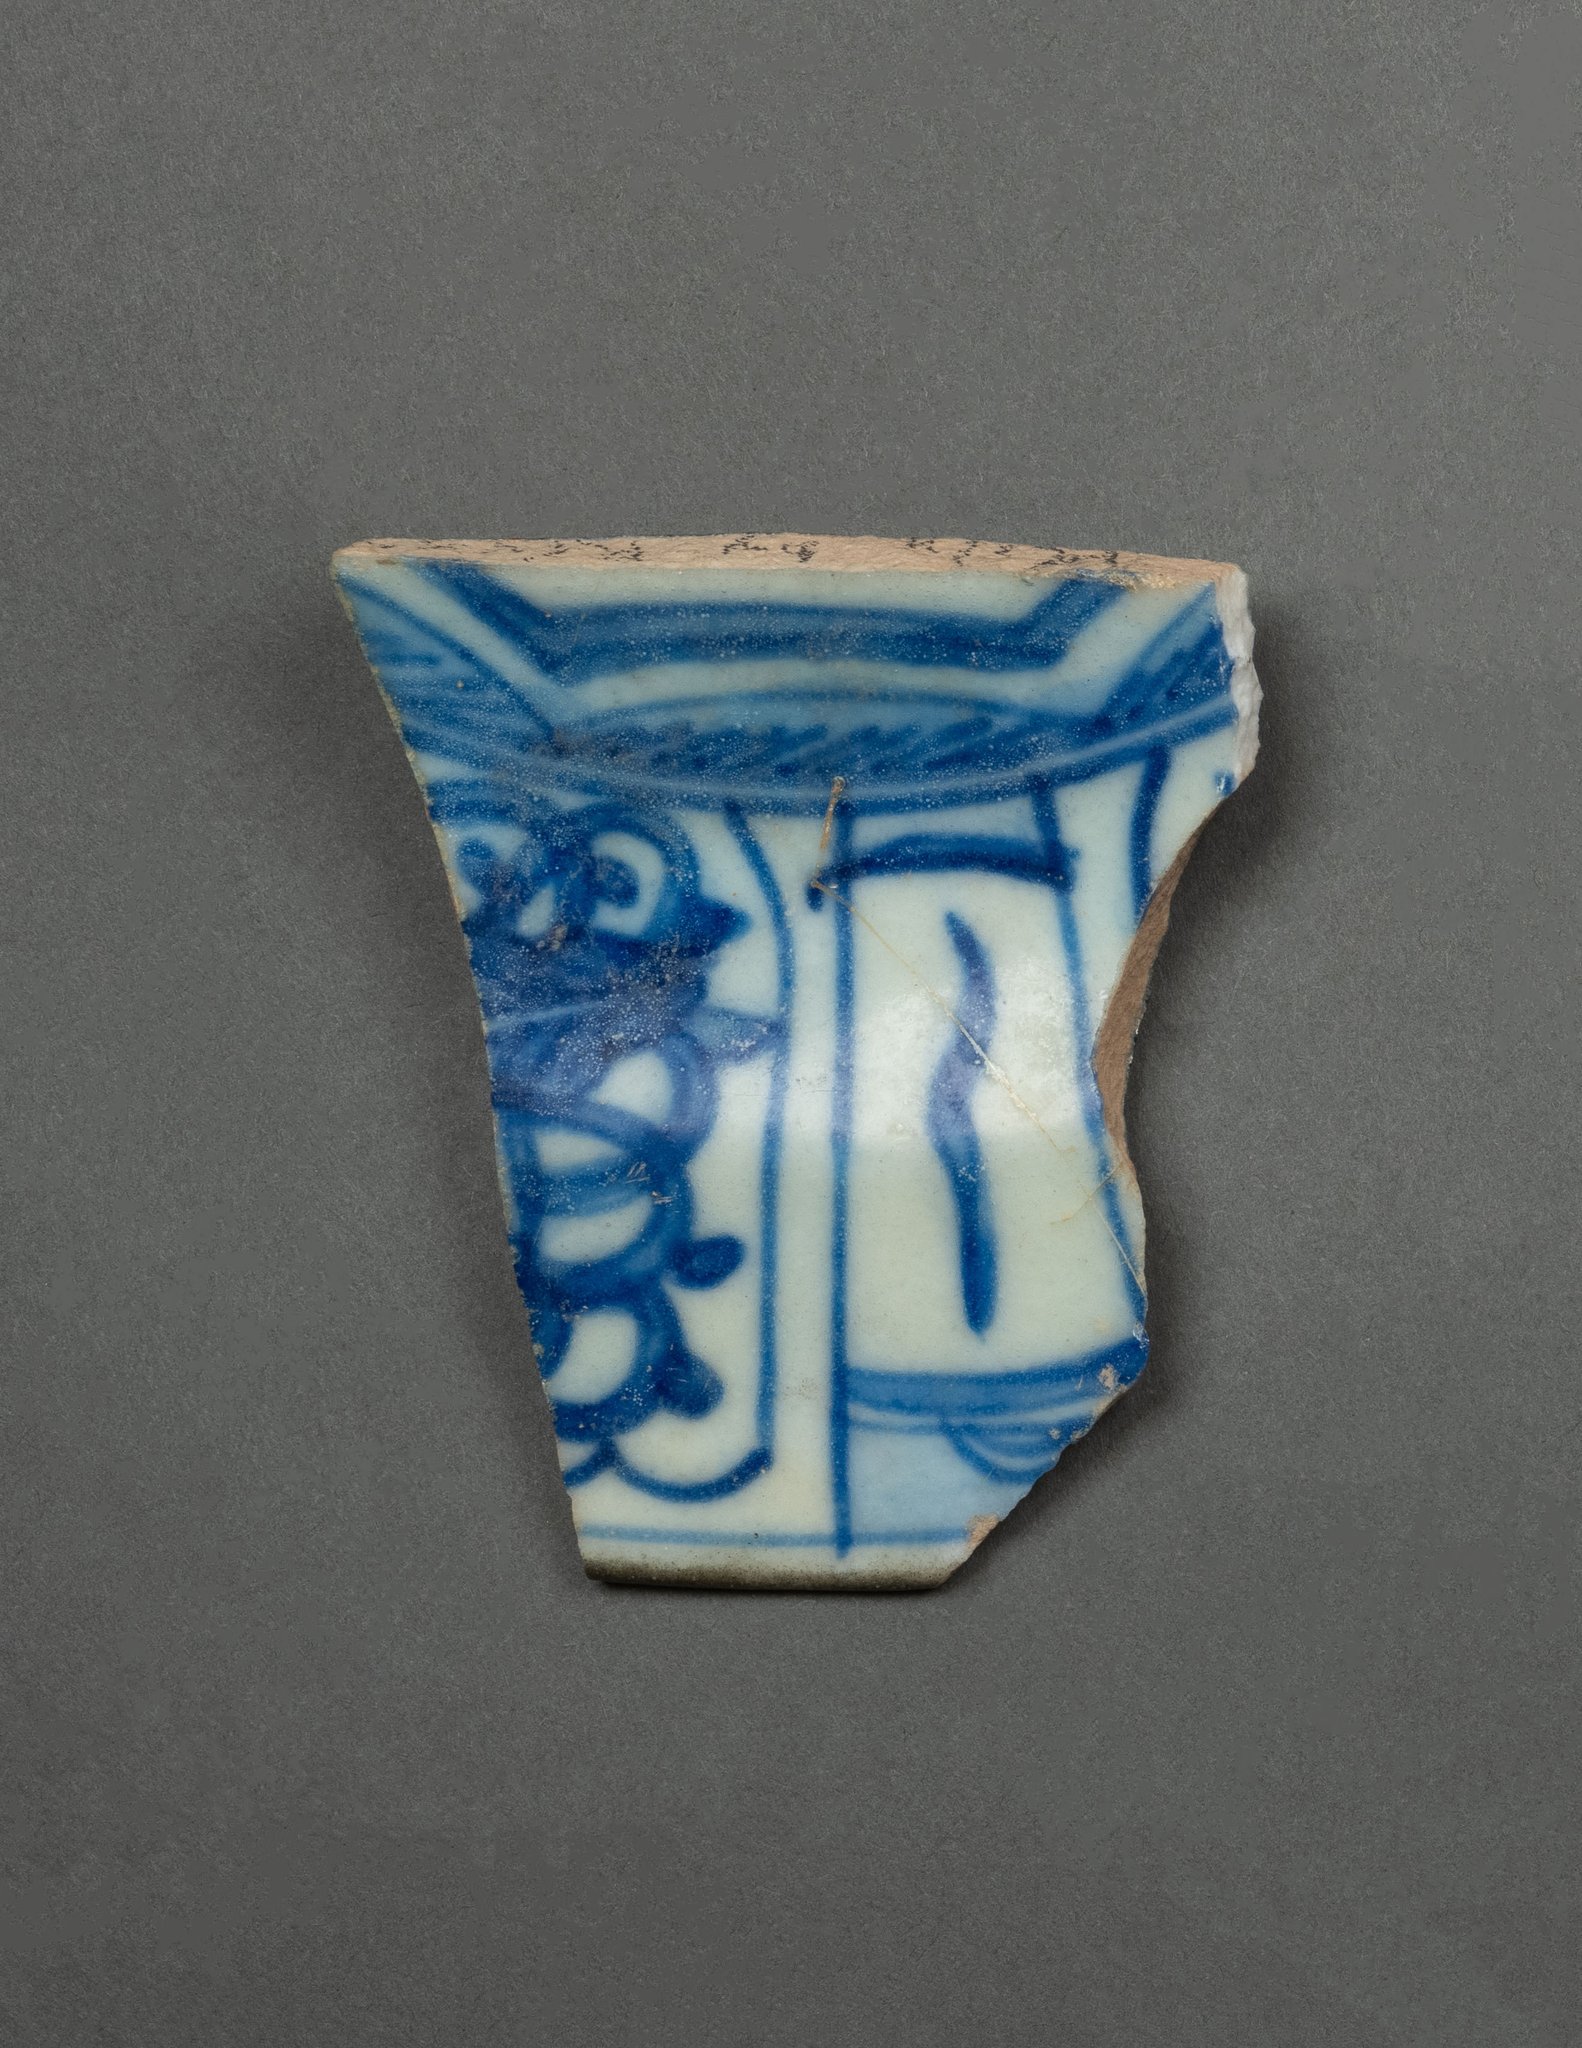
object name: fragment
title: Ceramic Fragment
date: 1501-1600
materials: earthenware, glaze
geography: iran